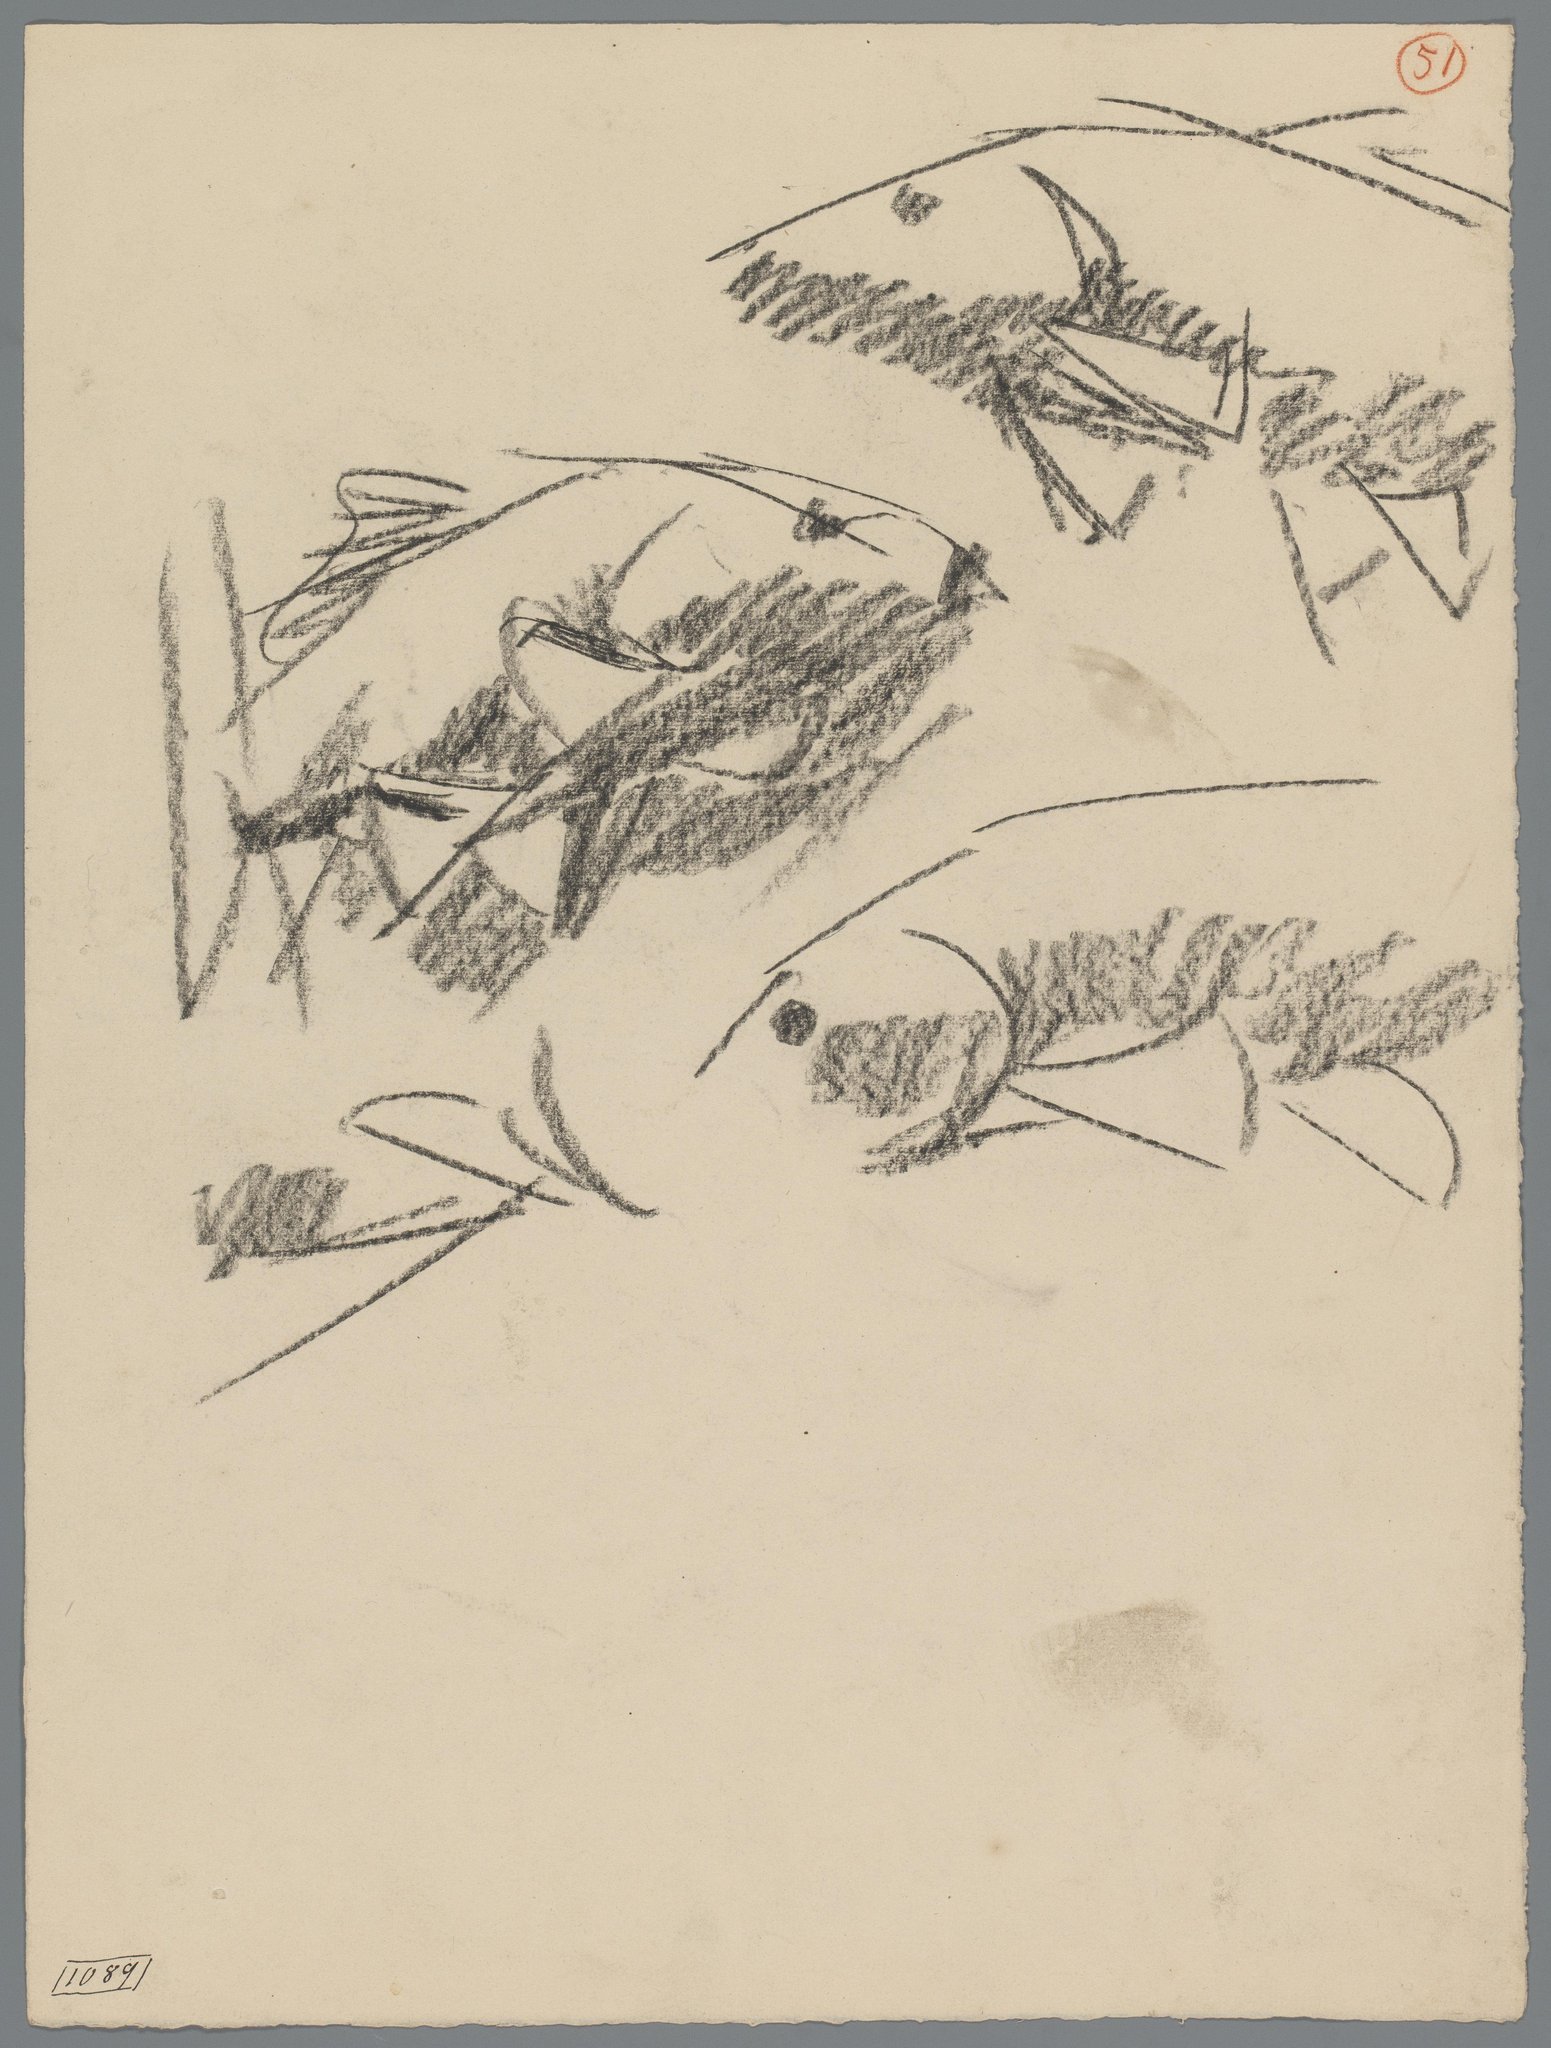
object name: drawing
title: Studies van karpers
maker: gerrit willem dijsselhof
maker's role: designer, draughtsman, print maker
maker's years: 1866-1924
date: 1876-1924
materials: chalk, paper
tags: bony fishes: carp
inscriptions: number: ‘1089’